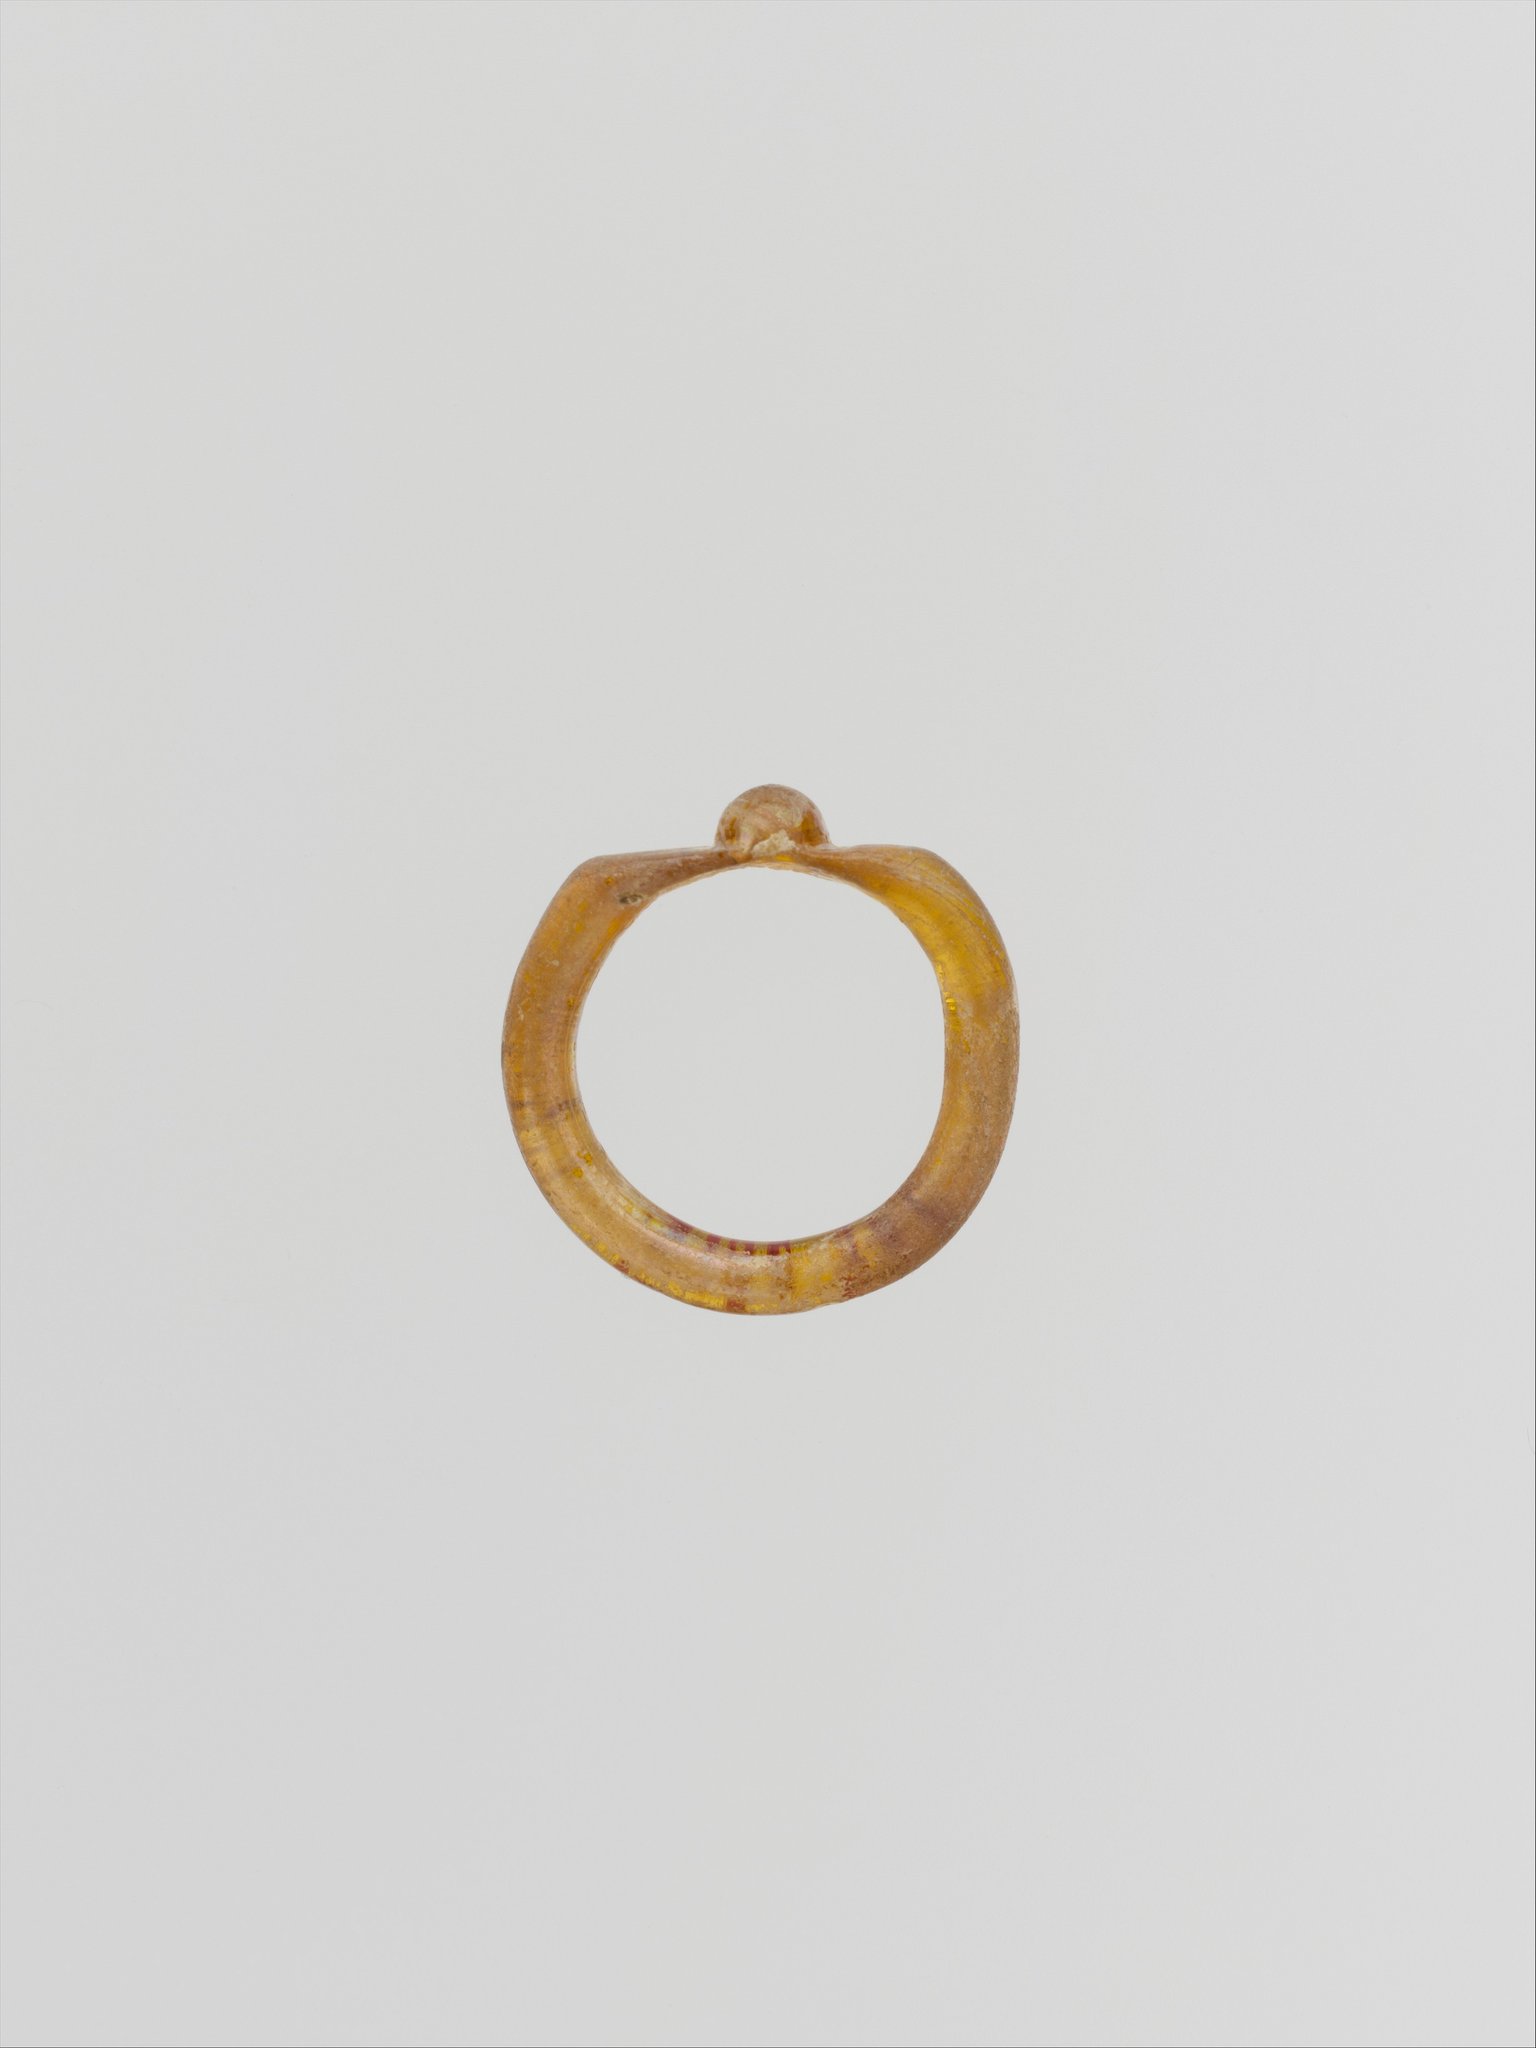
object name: ring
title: Glass finger ring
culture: roman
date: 101-300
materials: glass